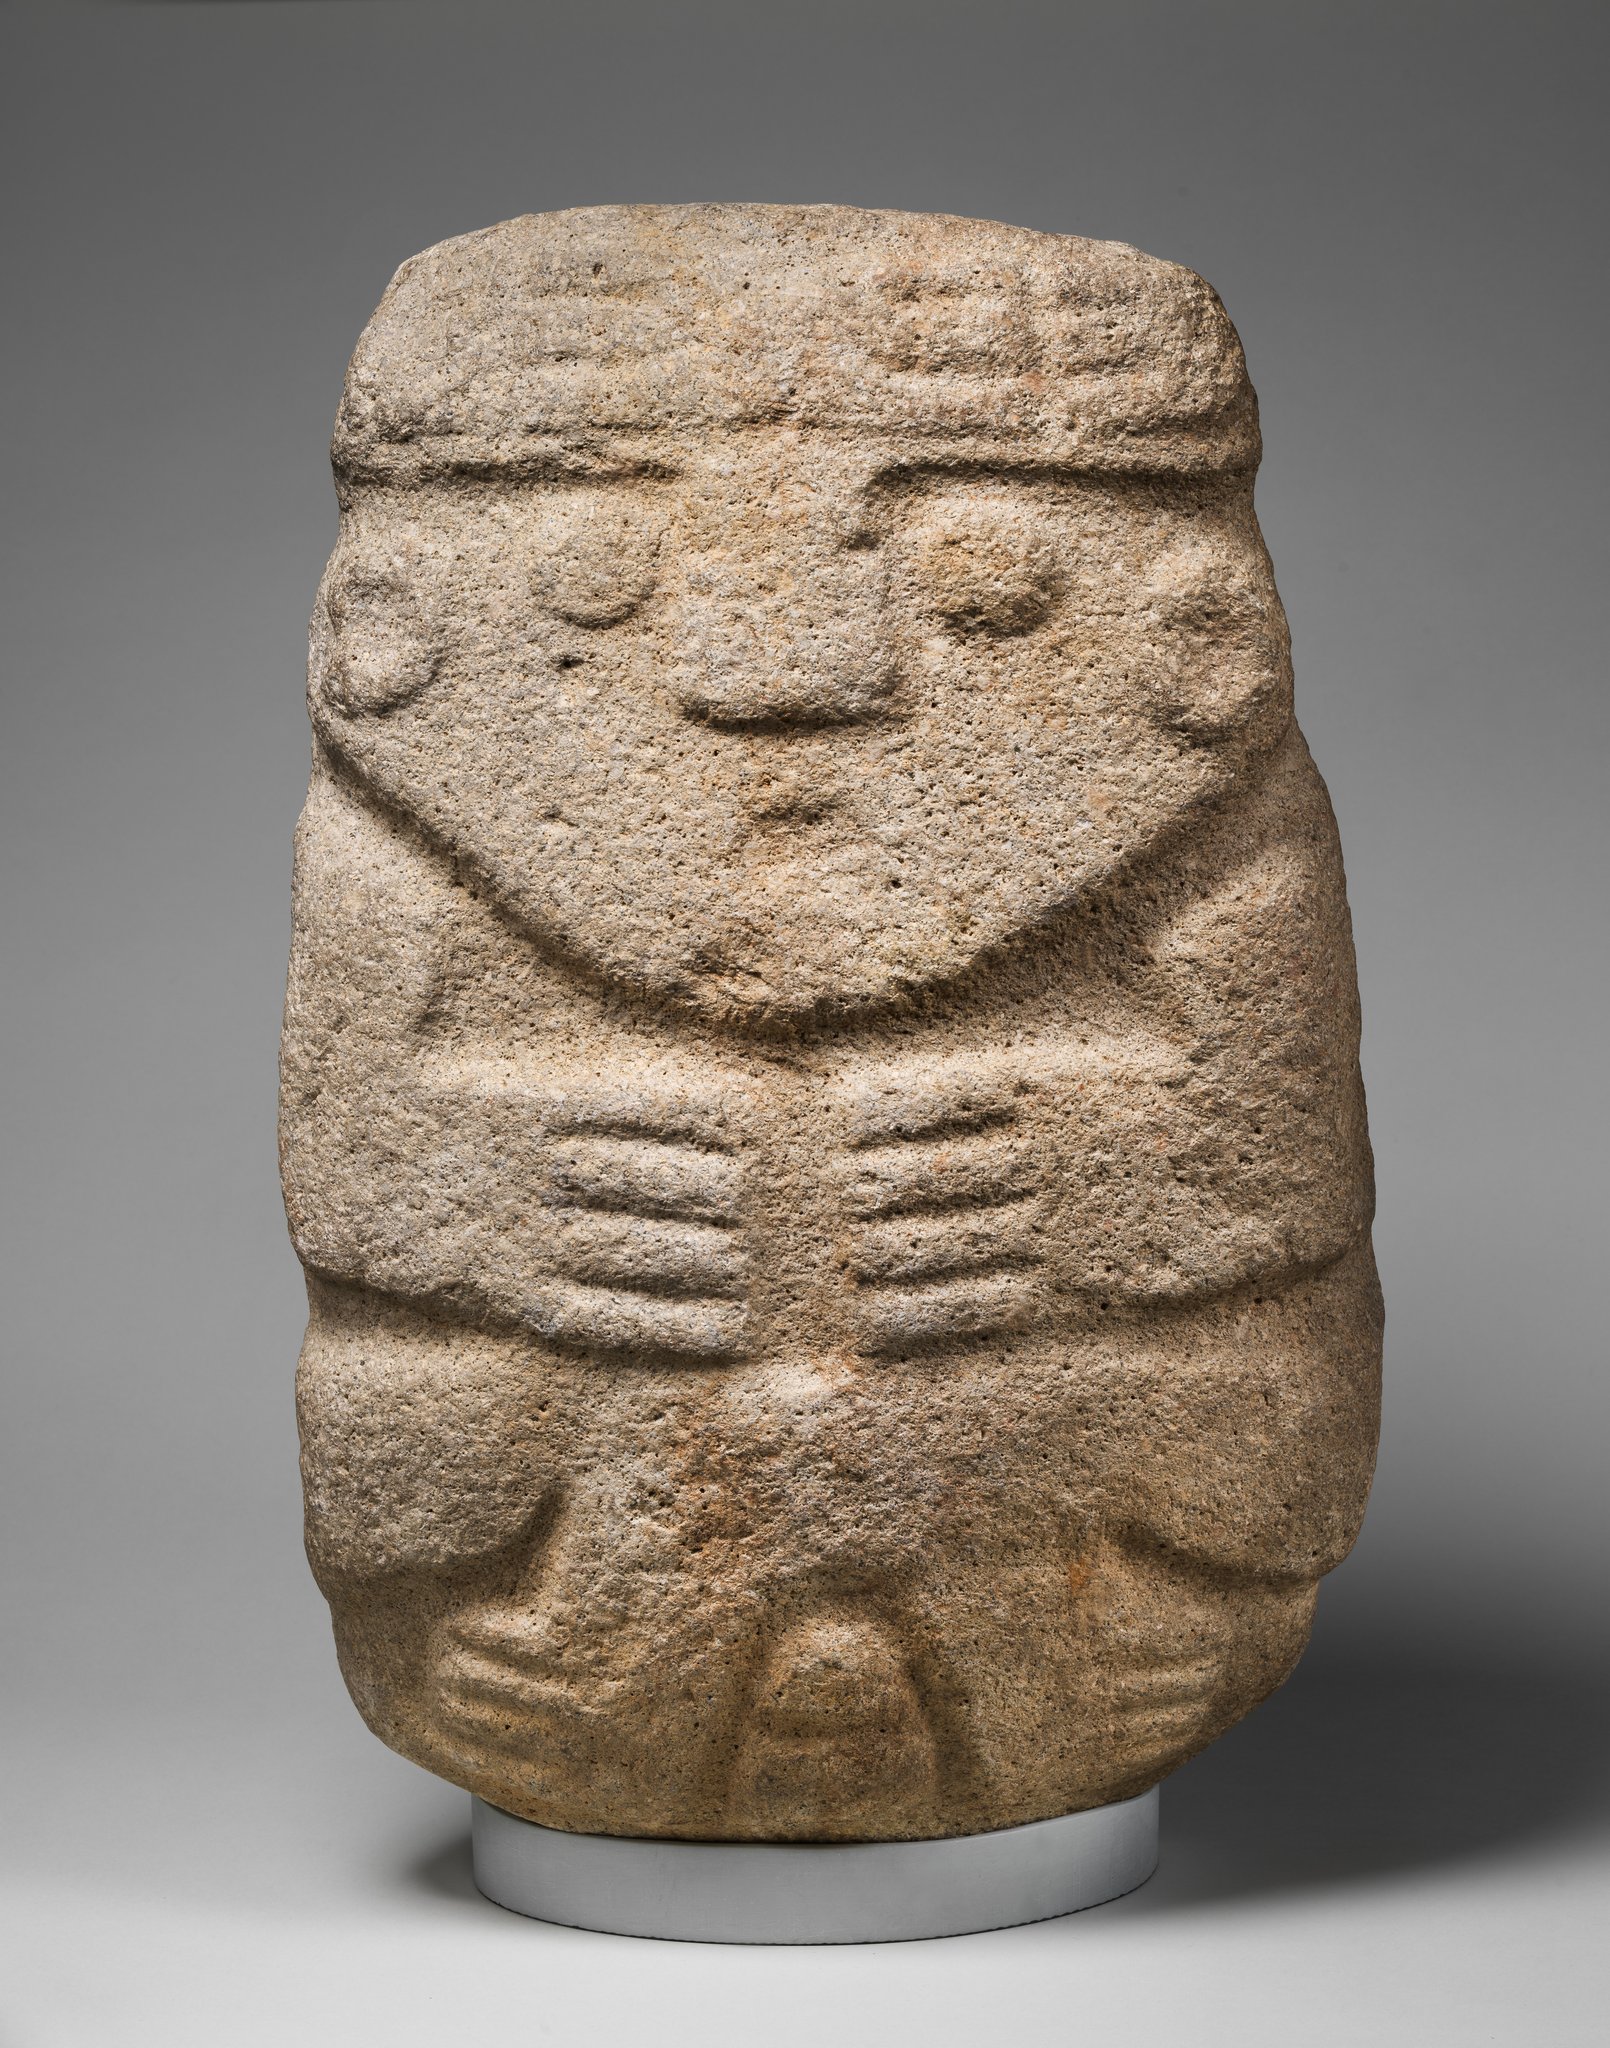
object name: figure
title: Boulder figure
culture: recuay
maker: recuay artist(s)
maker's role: artist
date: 200-700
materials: stone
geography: peru